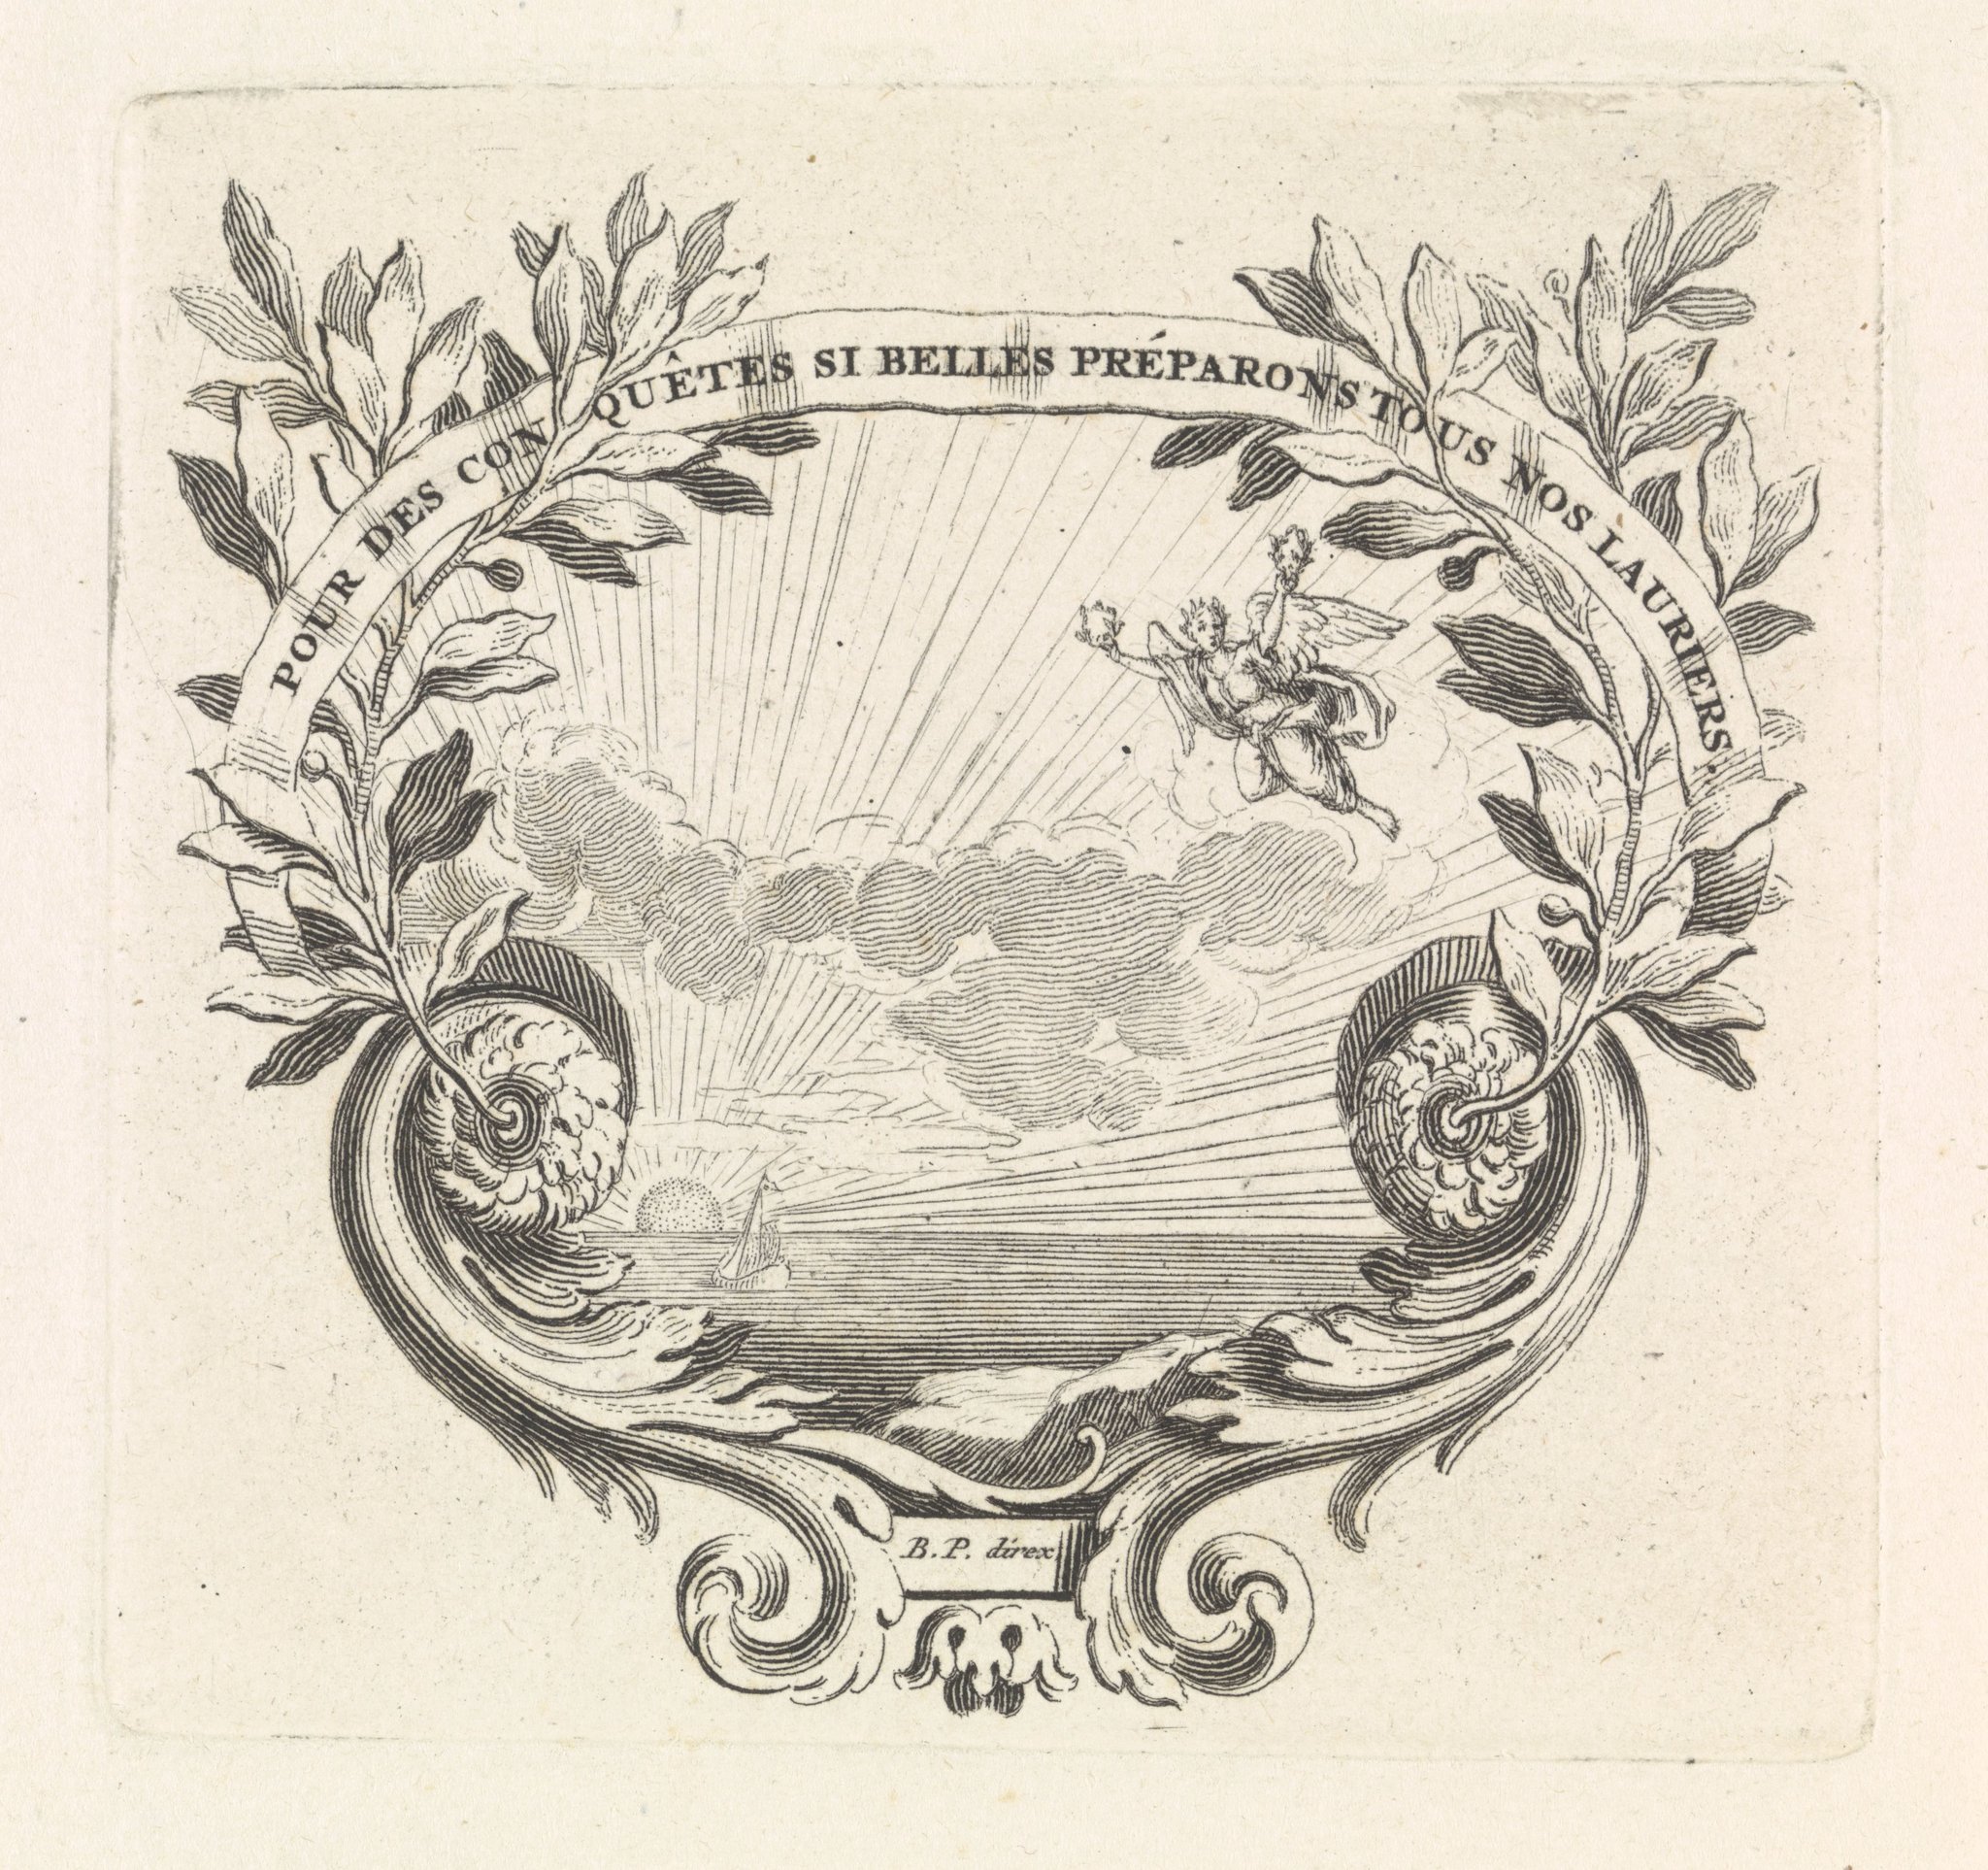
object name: print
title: Ornamenteel cartouche met ondergaande zon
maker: bernard picart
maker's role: draughtsman, print maker, publisher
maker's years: 1673-1733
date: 1683-1733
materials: paper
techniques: engraving, etching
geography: amsterdam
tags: sunset, crowning with laurel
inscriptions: collector's mark: Lugt 2228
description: Ornamenteel cartouche met een schip dat richting de ondergaande zon vaart. Een engel vliegt met twee lauwerkransen. Boven de voorstelling het devies: Pour des conquètes si belles préparons tous nos lauriers.